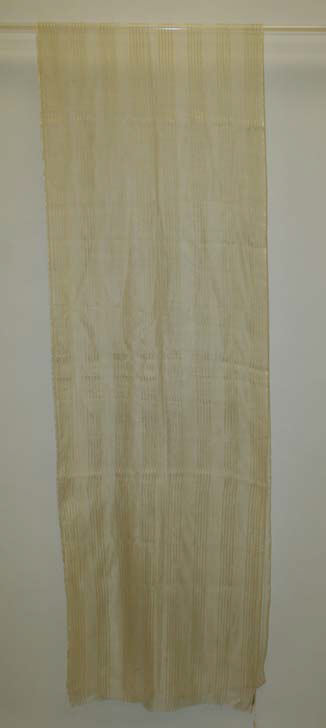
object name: scarf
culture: american or european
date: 1700-1945